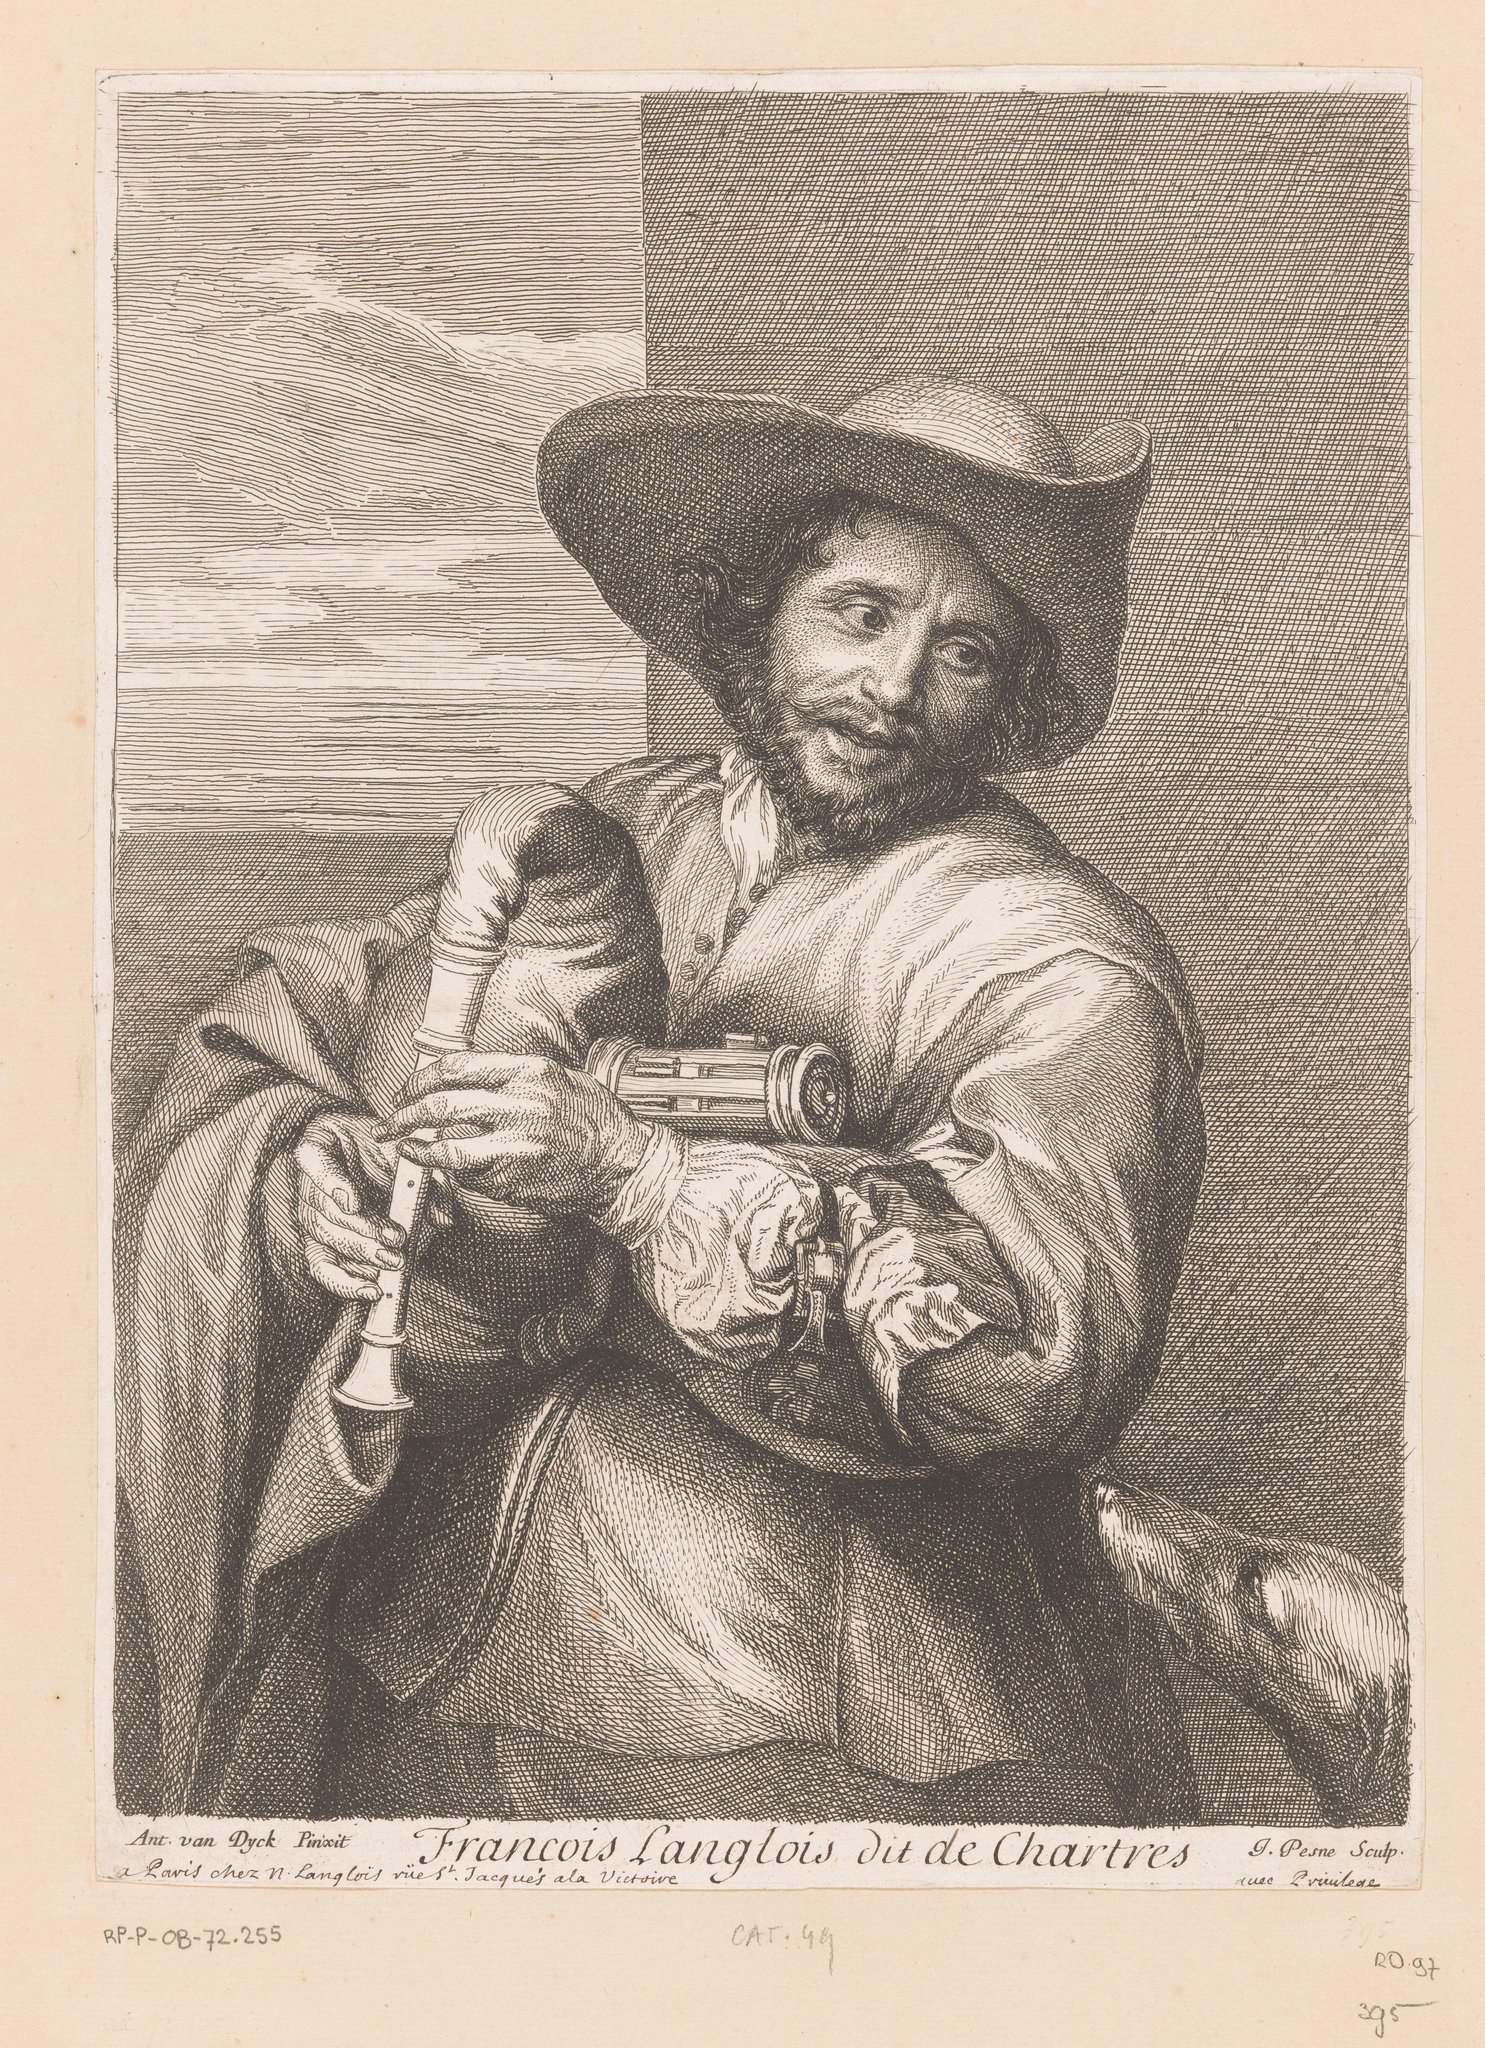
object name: print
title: Portrait of François Langlois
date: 1633-1700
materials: paper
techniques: engraving, etching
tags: paris, print maker, publisher, françois langlois, musician, historical persons, portrait, self-portrait of graphic artist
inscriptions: : ‘Francois Langlois dit de Chartres’, : ‘a Paris chez N. Langlois rüe St. Jacques a la Victoire avec Privilege’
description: This is François Langlois, who made his living in Paris in the first half of the 17th century as an engraver, print publisher, bookseller and art dealer. He was also a gifted musette player – a type of bagpipe in which air is pumped by means of a bellows. The instrument, which produces a modest sound, was popular at the French court for playing dance music.